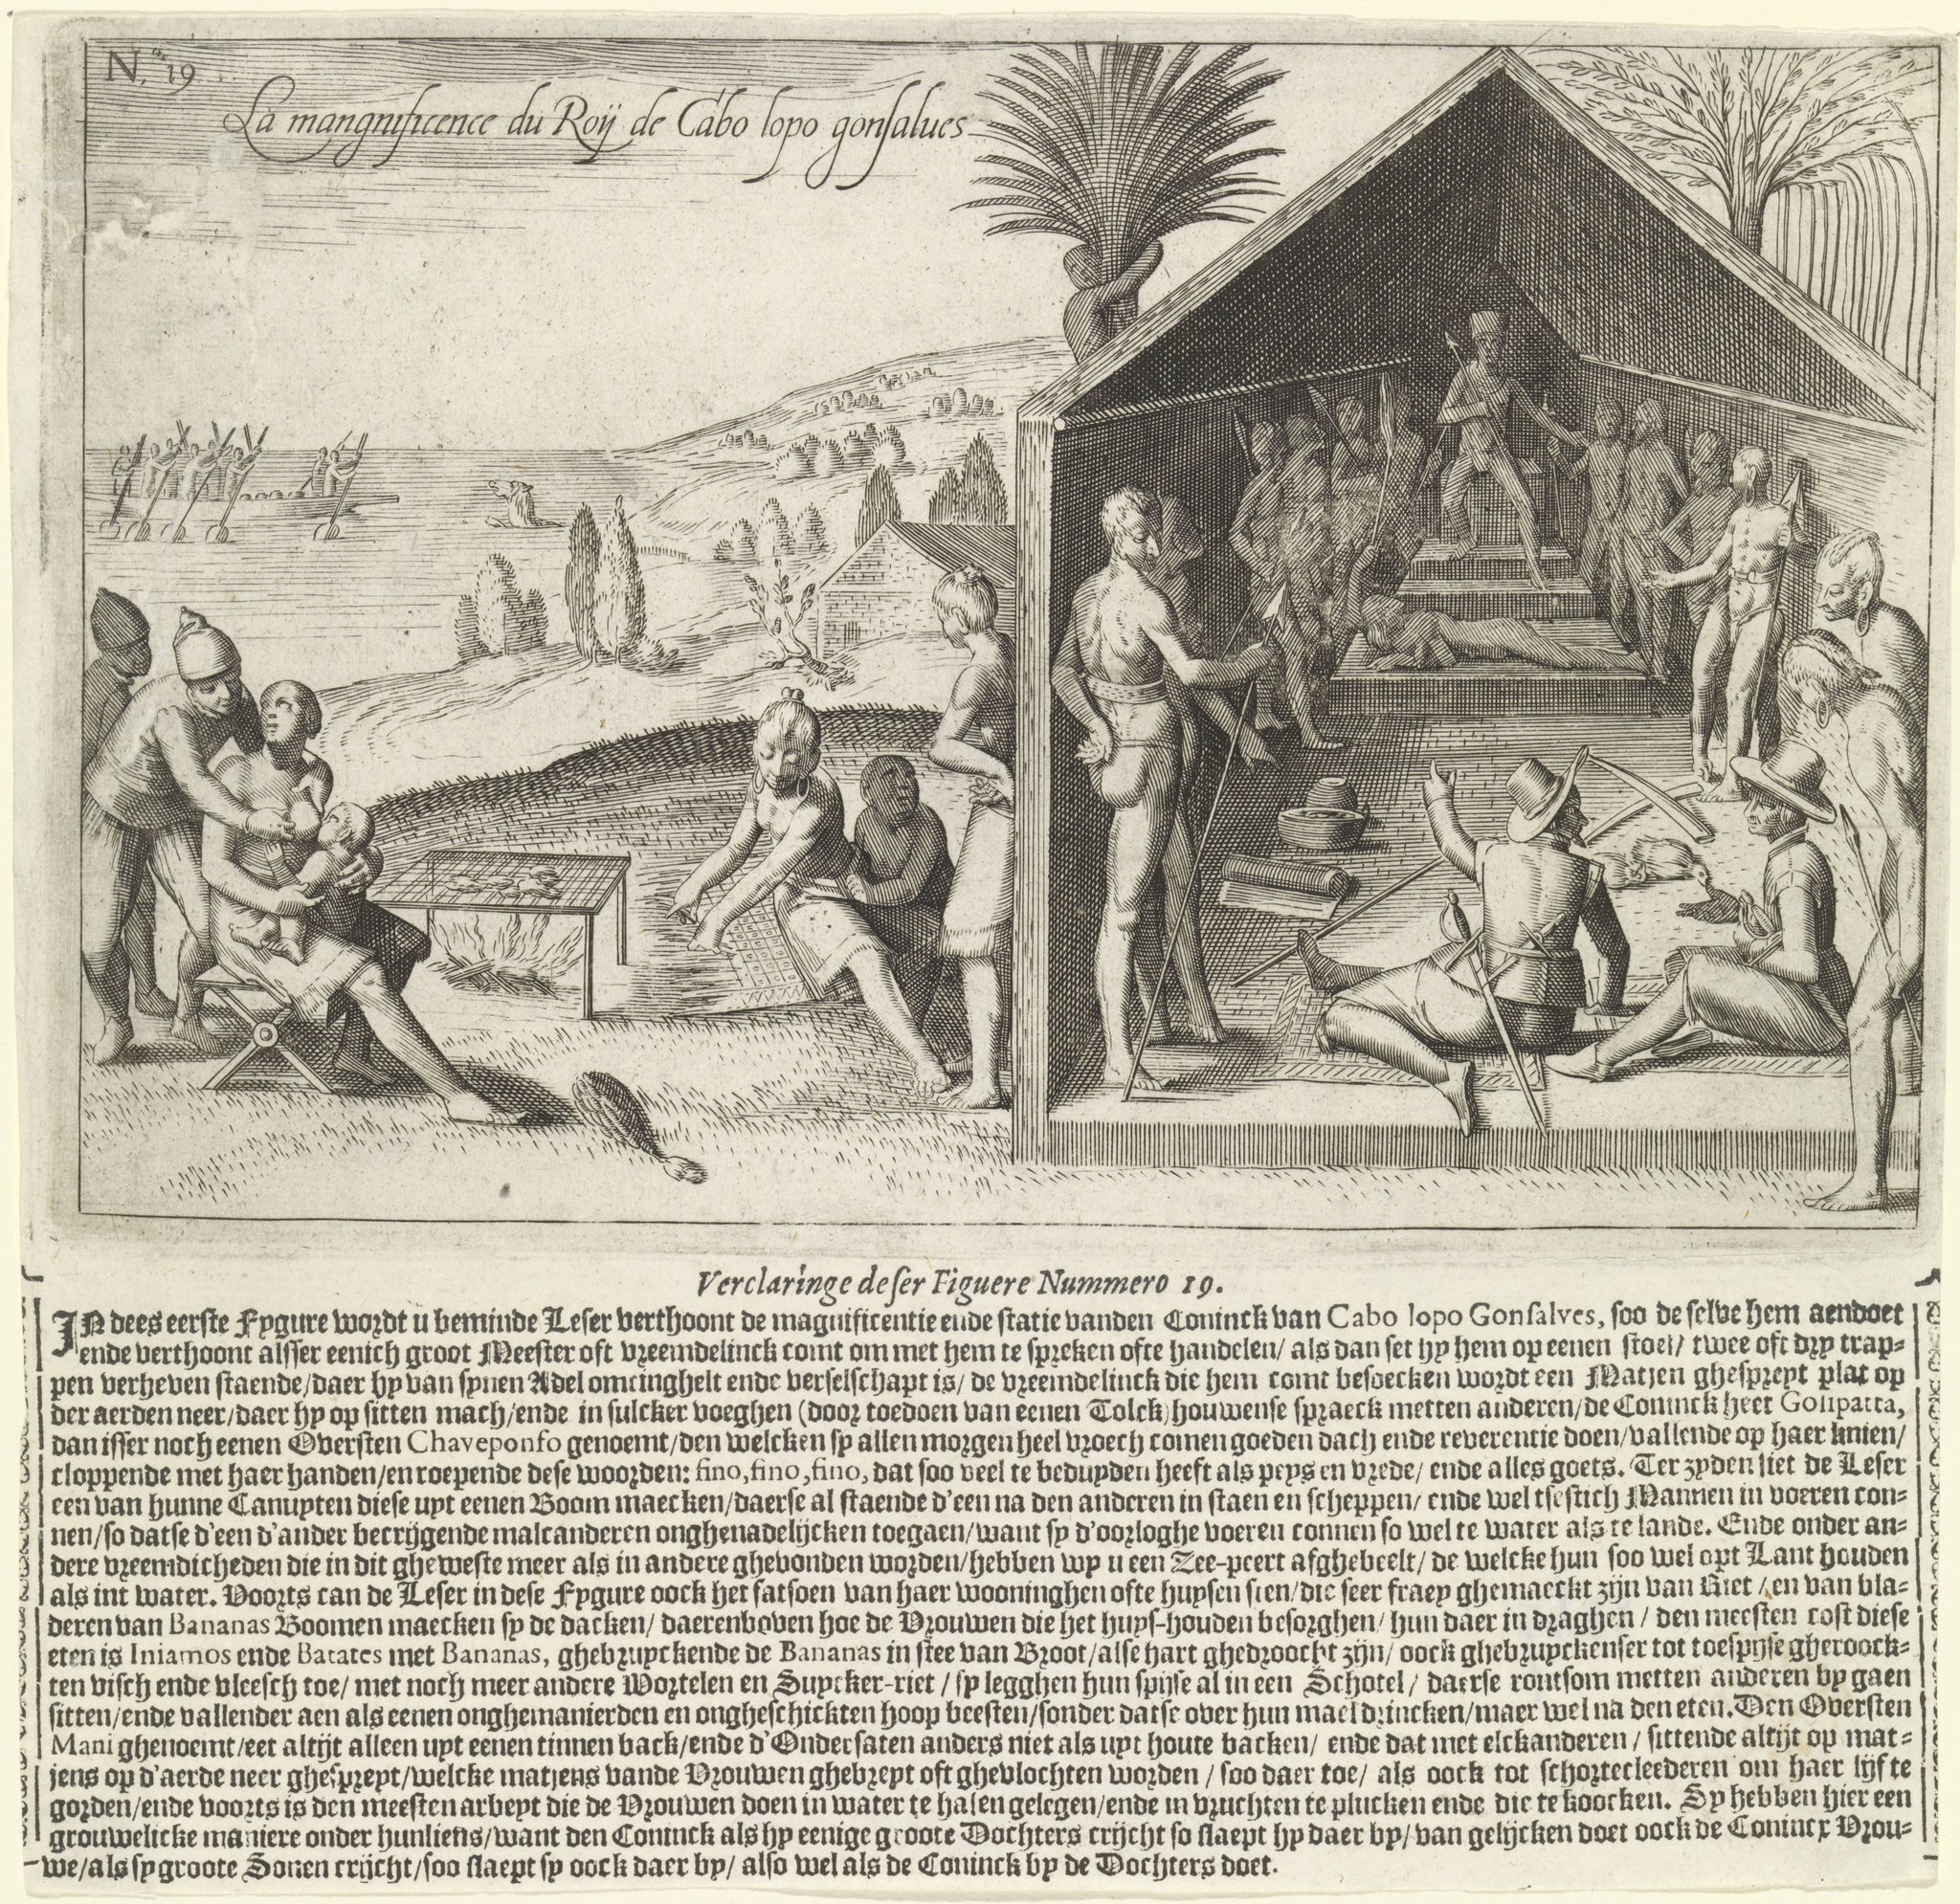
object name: print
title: Het hof van de koning van Kaap de Lopo Gonsalves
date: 1602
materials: paper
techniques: engraving, letterpress printing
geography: frankfurt am main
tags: family of a ruler, and court, africans (+ anthropological characteristics emphasized), king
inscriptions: collector's mark: Lugt 240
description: Links het leven aan het hof. De vrouwen zitten buiten en vlechten matten en zorgen voor de kinderen. Rechts is het huis van de koning te zien. Het is gemaakt van bananenbomen, het dak is van bananenbladeren. Twee westerlingen zijn op bezoek bij de koning.